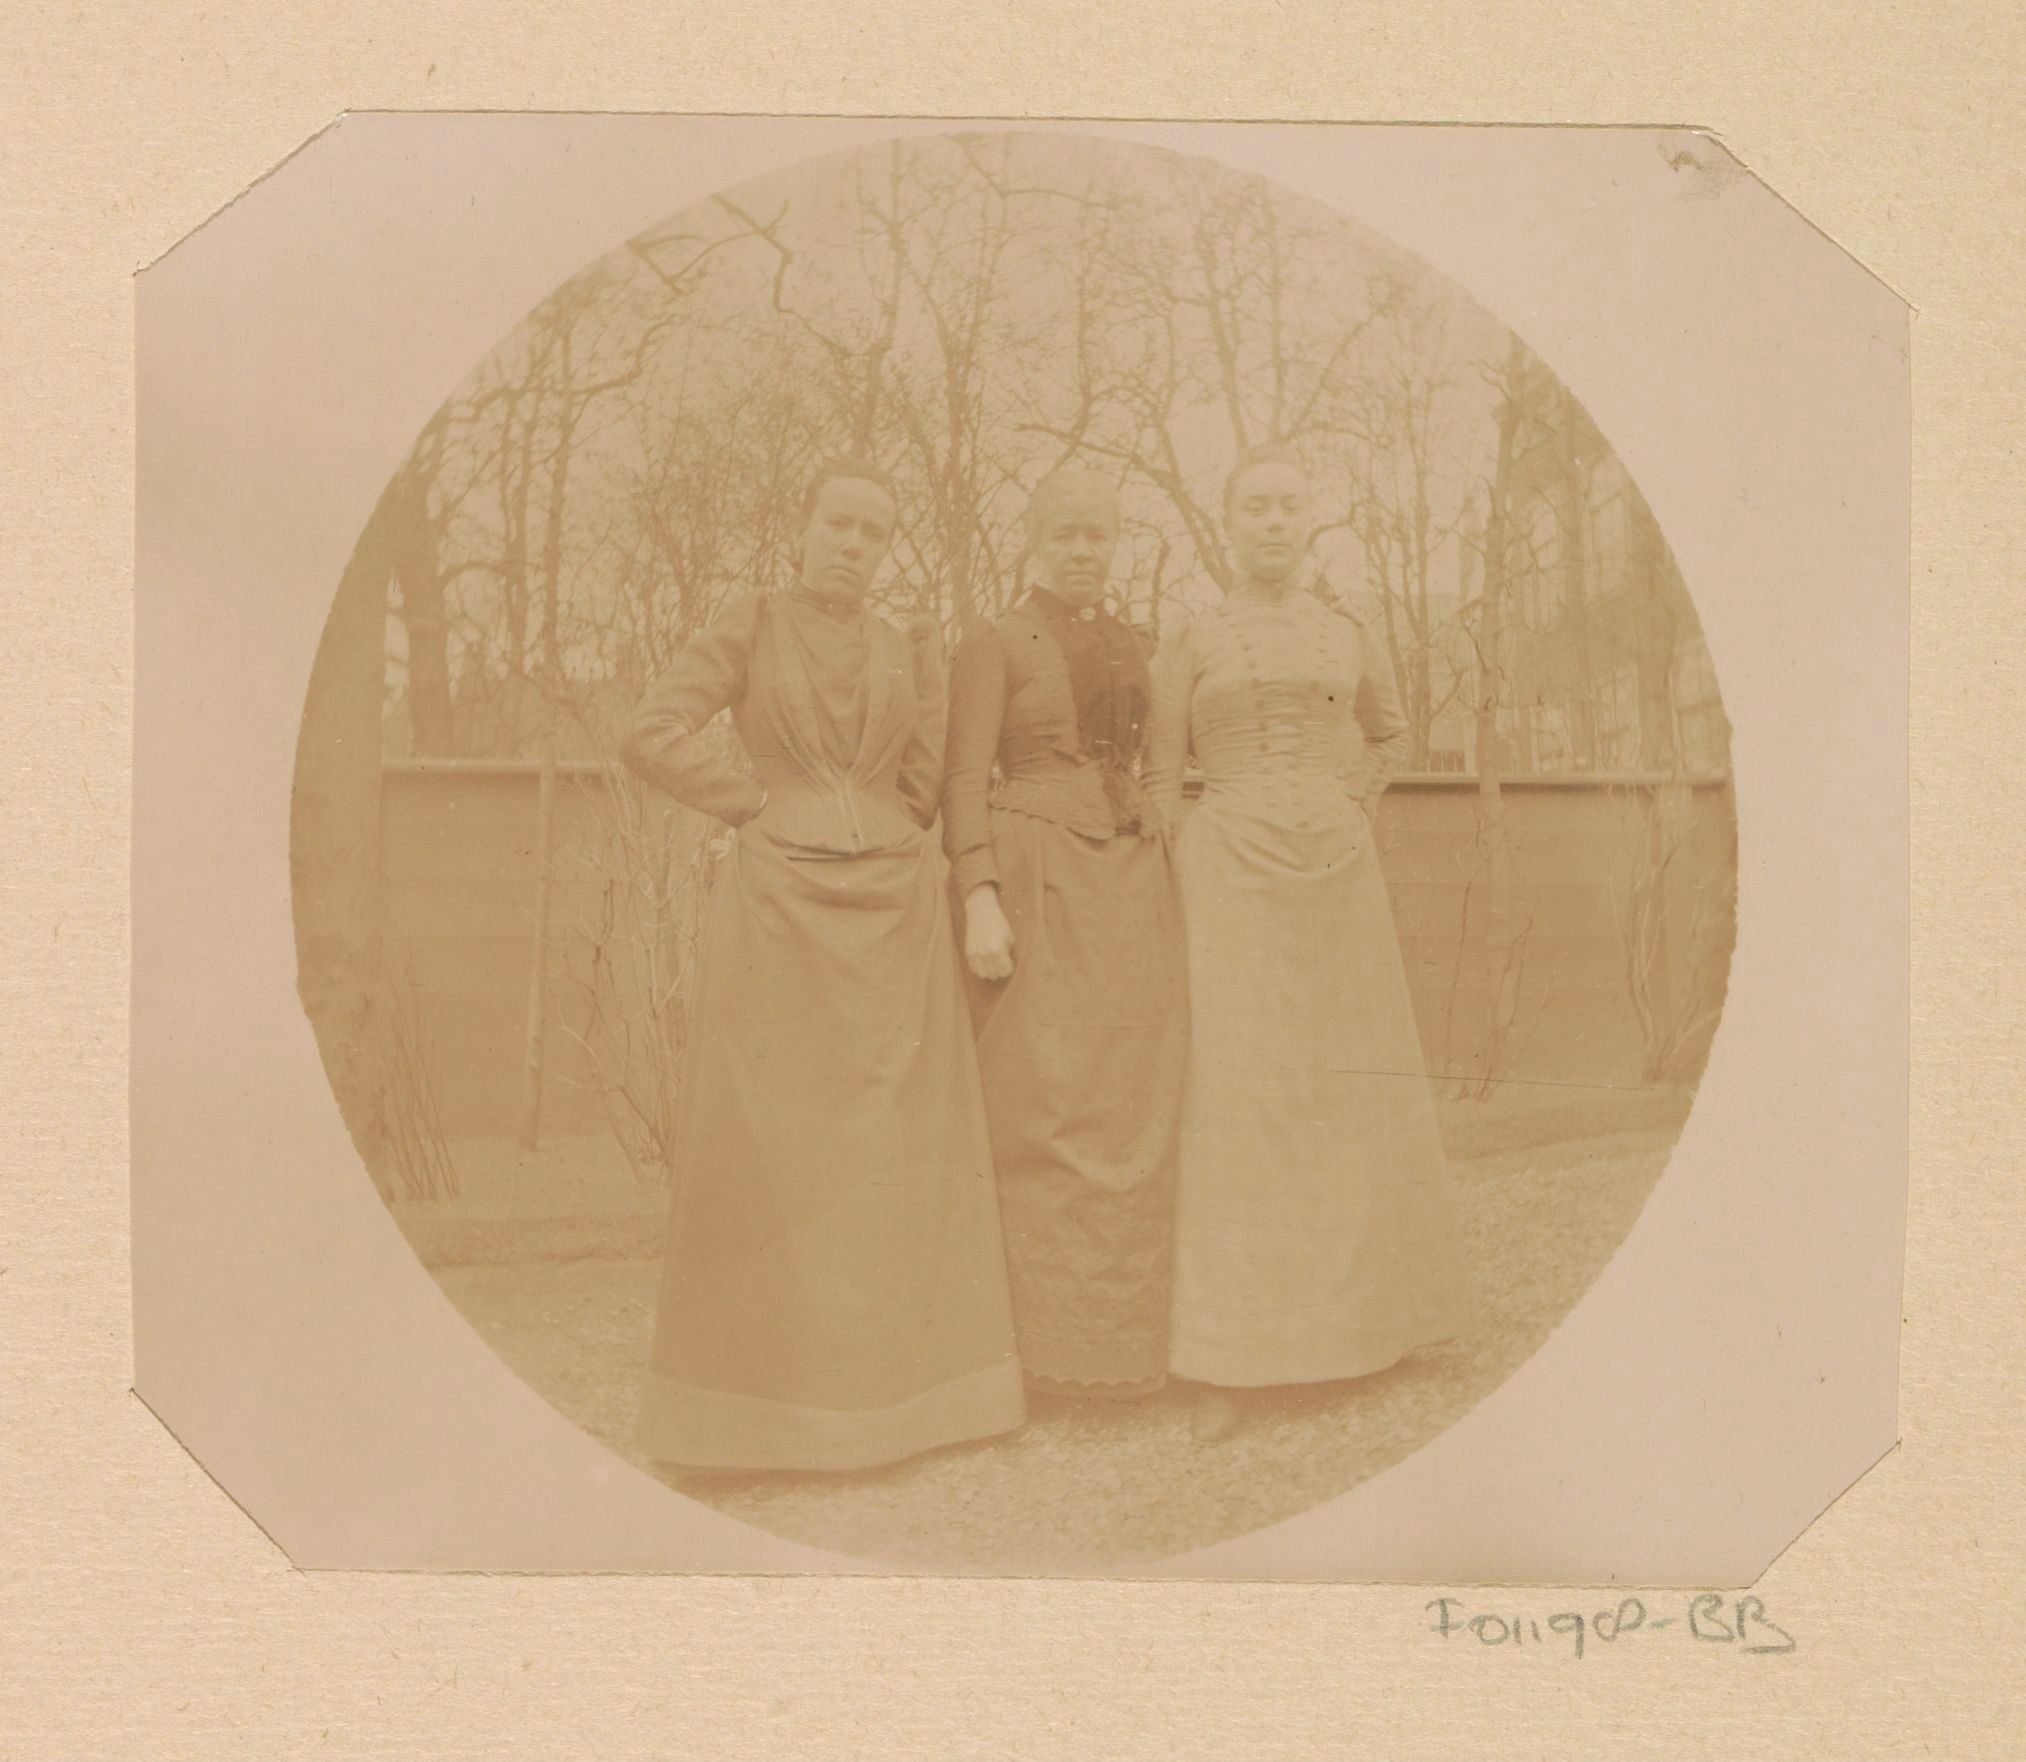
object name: photograph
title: Gesiena en Cato Piek met hun moeder, Lucia Wilhelmina Piek-Jolles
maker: johanna margaretha piek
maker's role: fotograaf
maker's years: 1870-1947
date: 1889-1893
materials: paper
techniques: gelatin silver print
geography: amsterdam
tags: amsterdam, adult woman